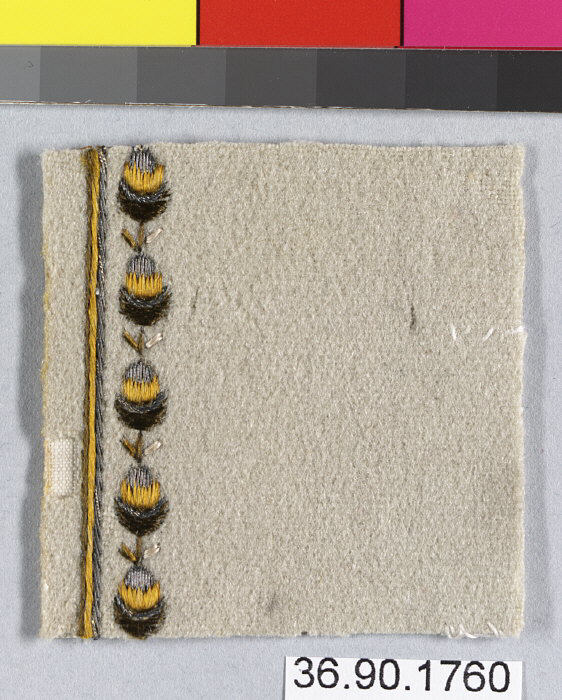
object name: sample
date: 1801-1833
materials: felt, metal thread, silk